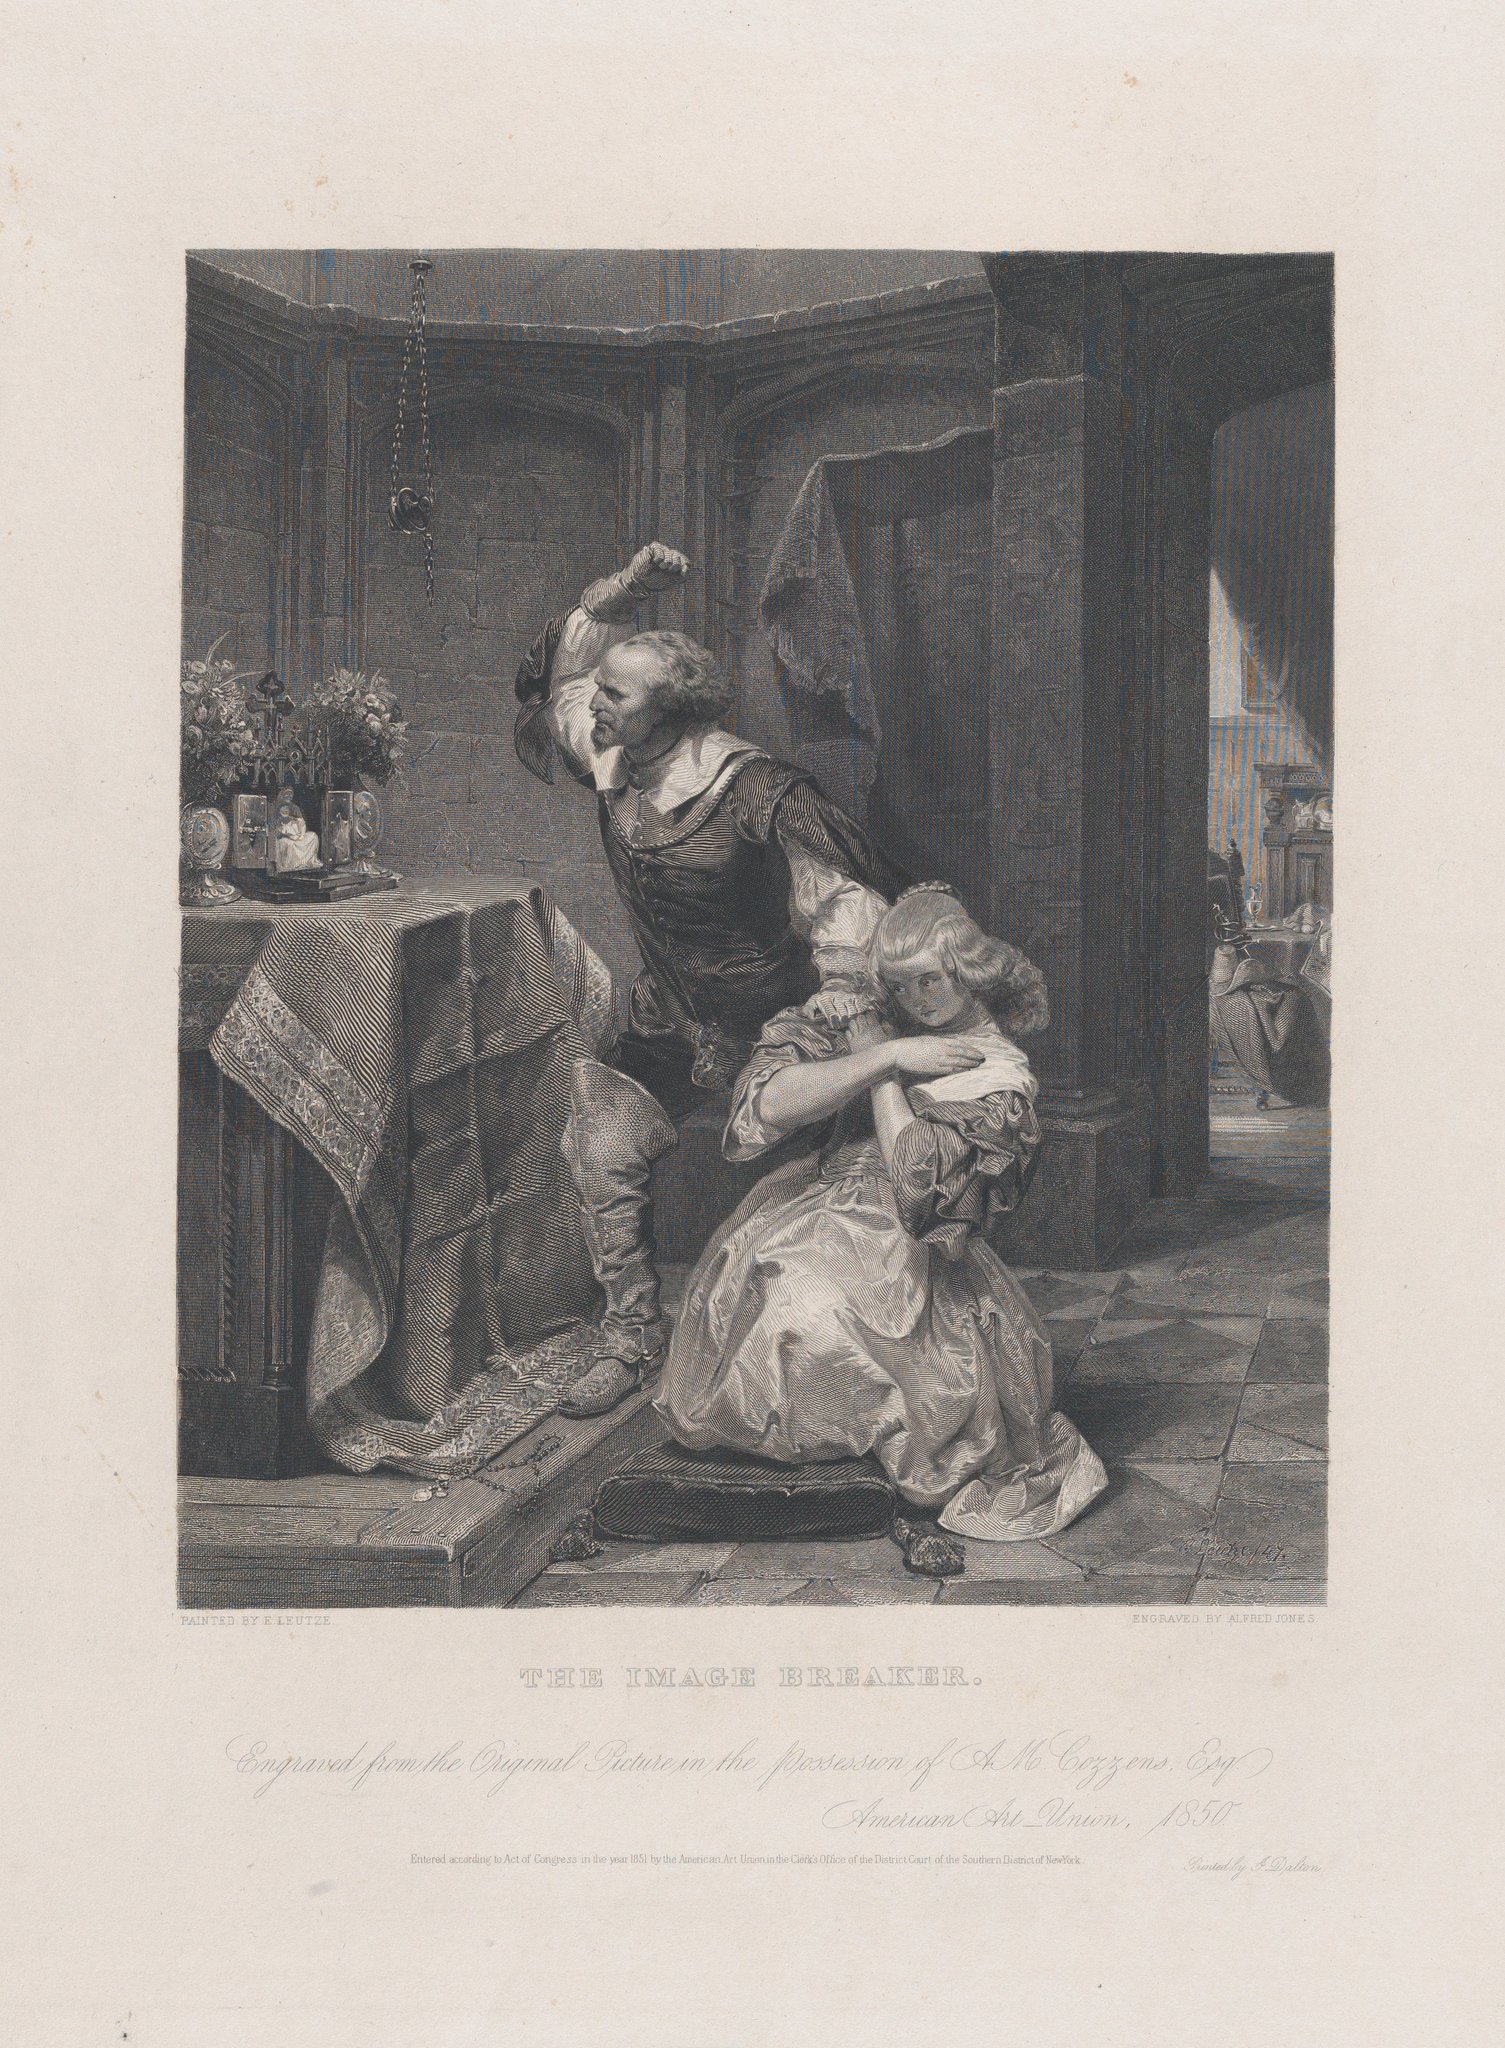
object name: print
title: The Image Breaker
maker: alfred jones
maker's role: engraver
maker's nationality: american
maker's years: 1819-1900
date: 1851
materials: steel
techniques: engraving, etching, stippling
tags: altars,interiors,anger,men,women